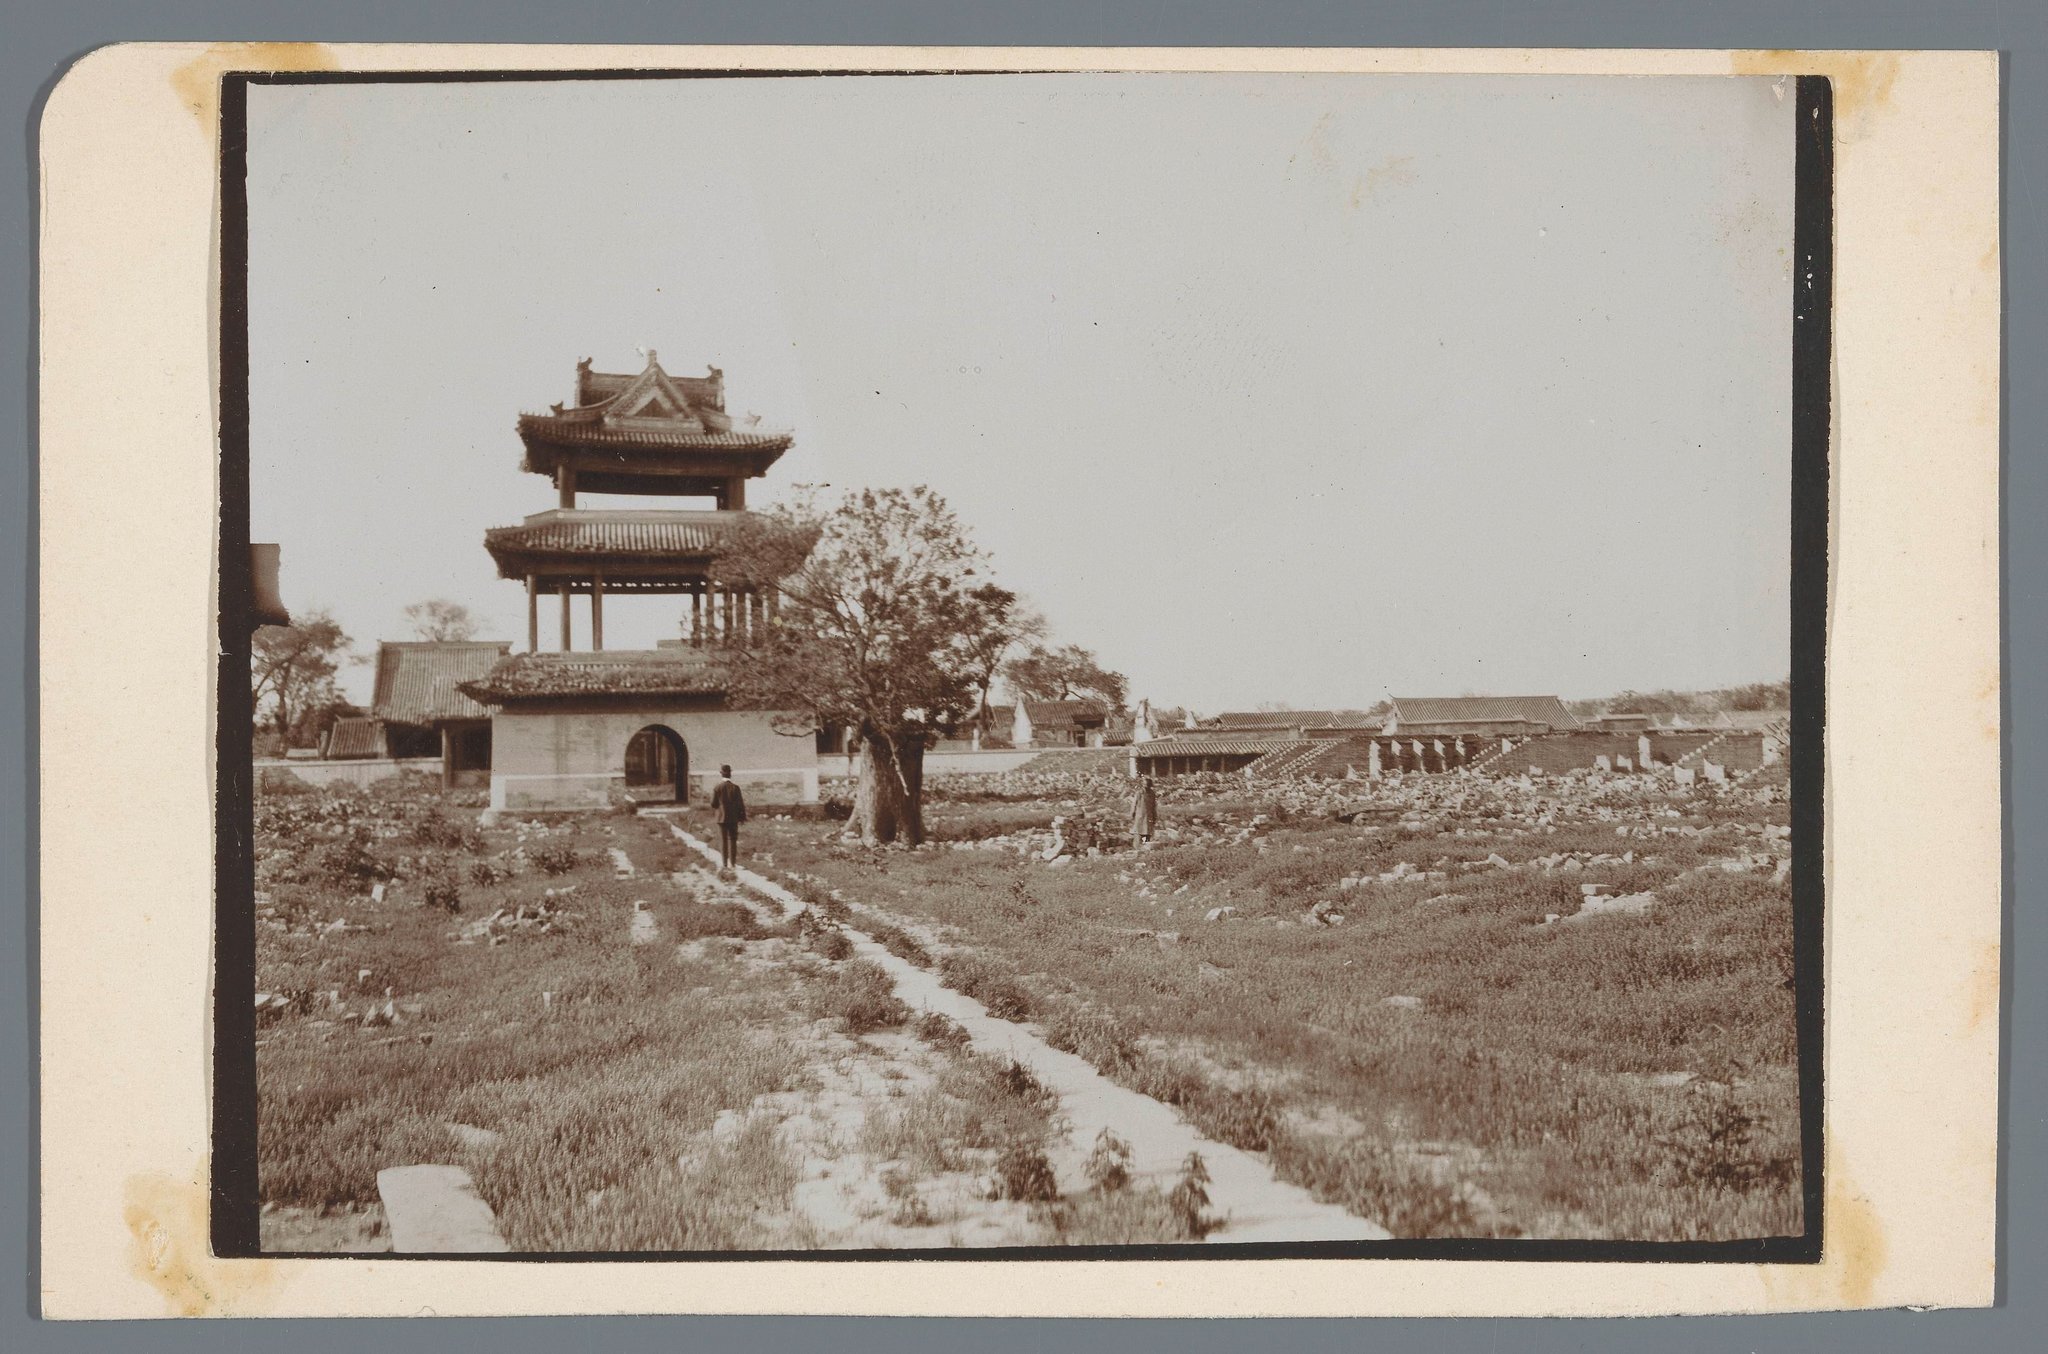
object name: photograph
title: Een gebouw (een tempel?) omgeven door enkele vervallen gebouwen, China?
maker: jan adriani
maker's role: fotograaf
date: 1907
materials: cardboard, photographic support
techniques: collodion silver print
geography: china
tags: temple, shrine ~ non-christian religions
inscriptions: inscription: ‘[B]estuurderen der Maatschappij / [A]rti et Amicitiae" hebben de eer u met uwe / (...) zondag 4 maart (...)’